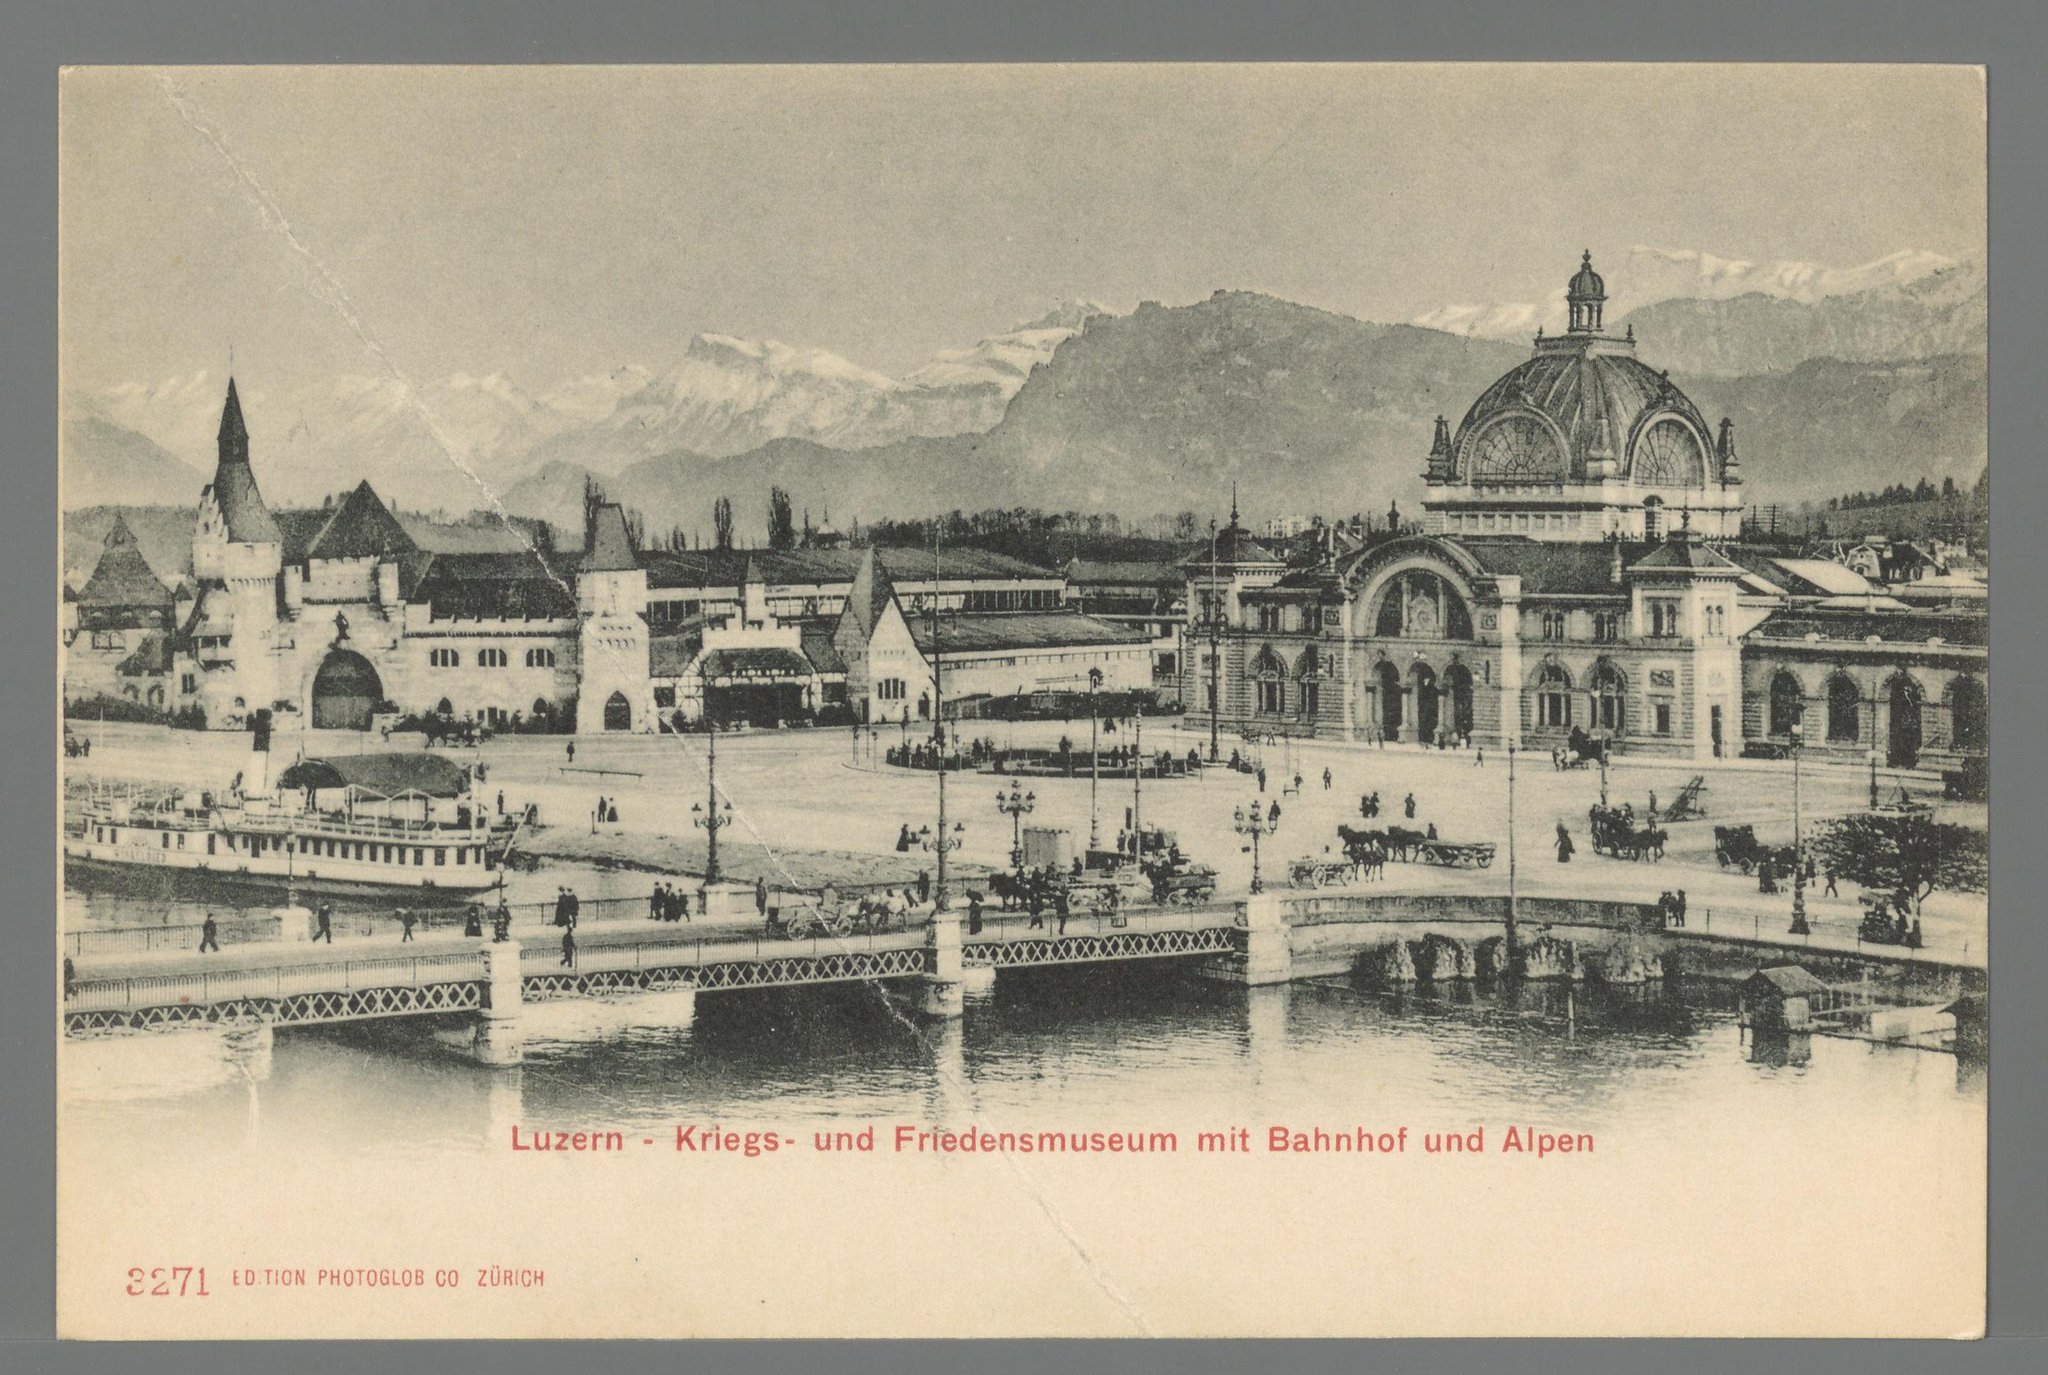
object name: photomechanical print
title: Luzern. Kriegs- und Friedensmuseum mit Bahnhof und Alpen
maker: Anonymous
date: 1895-1905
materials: cardboard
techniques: photograph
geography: zurich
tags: mountain-range, snow peaks, station; shelter (railway, tramway), city-view, and landscape with man-made constructions (+ city(-scape) with figures, staffage)